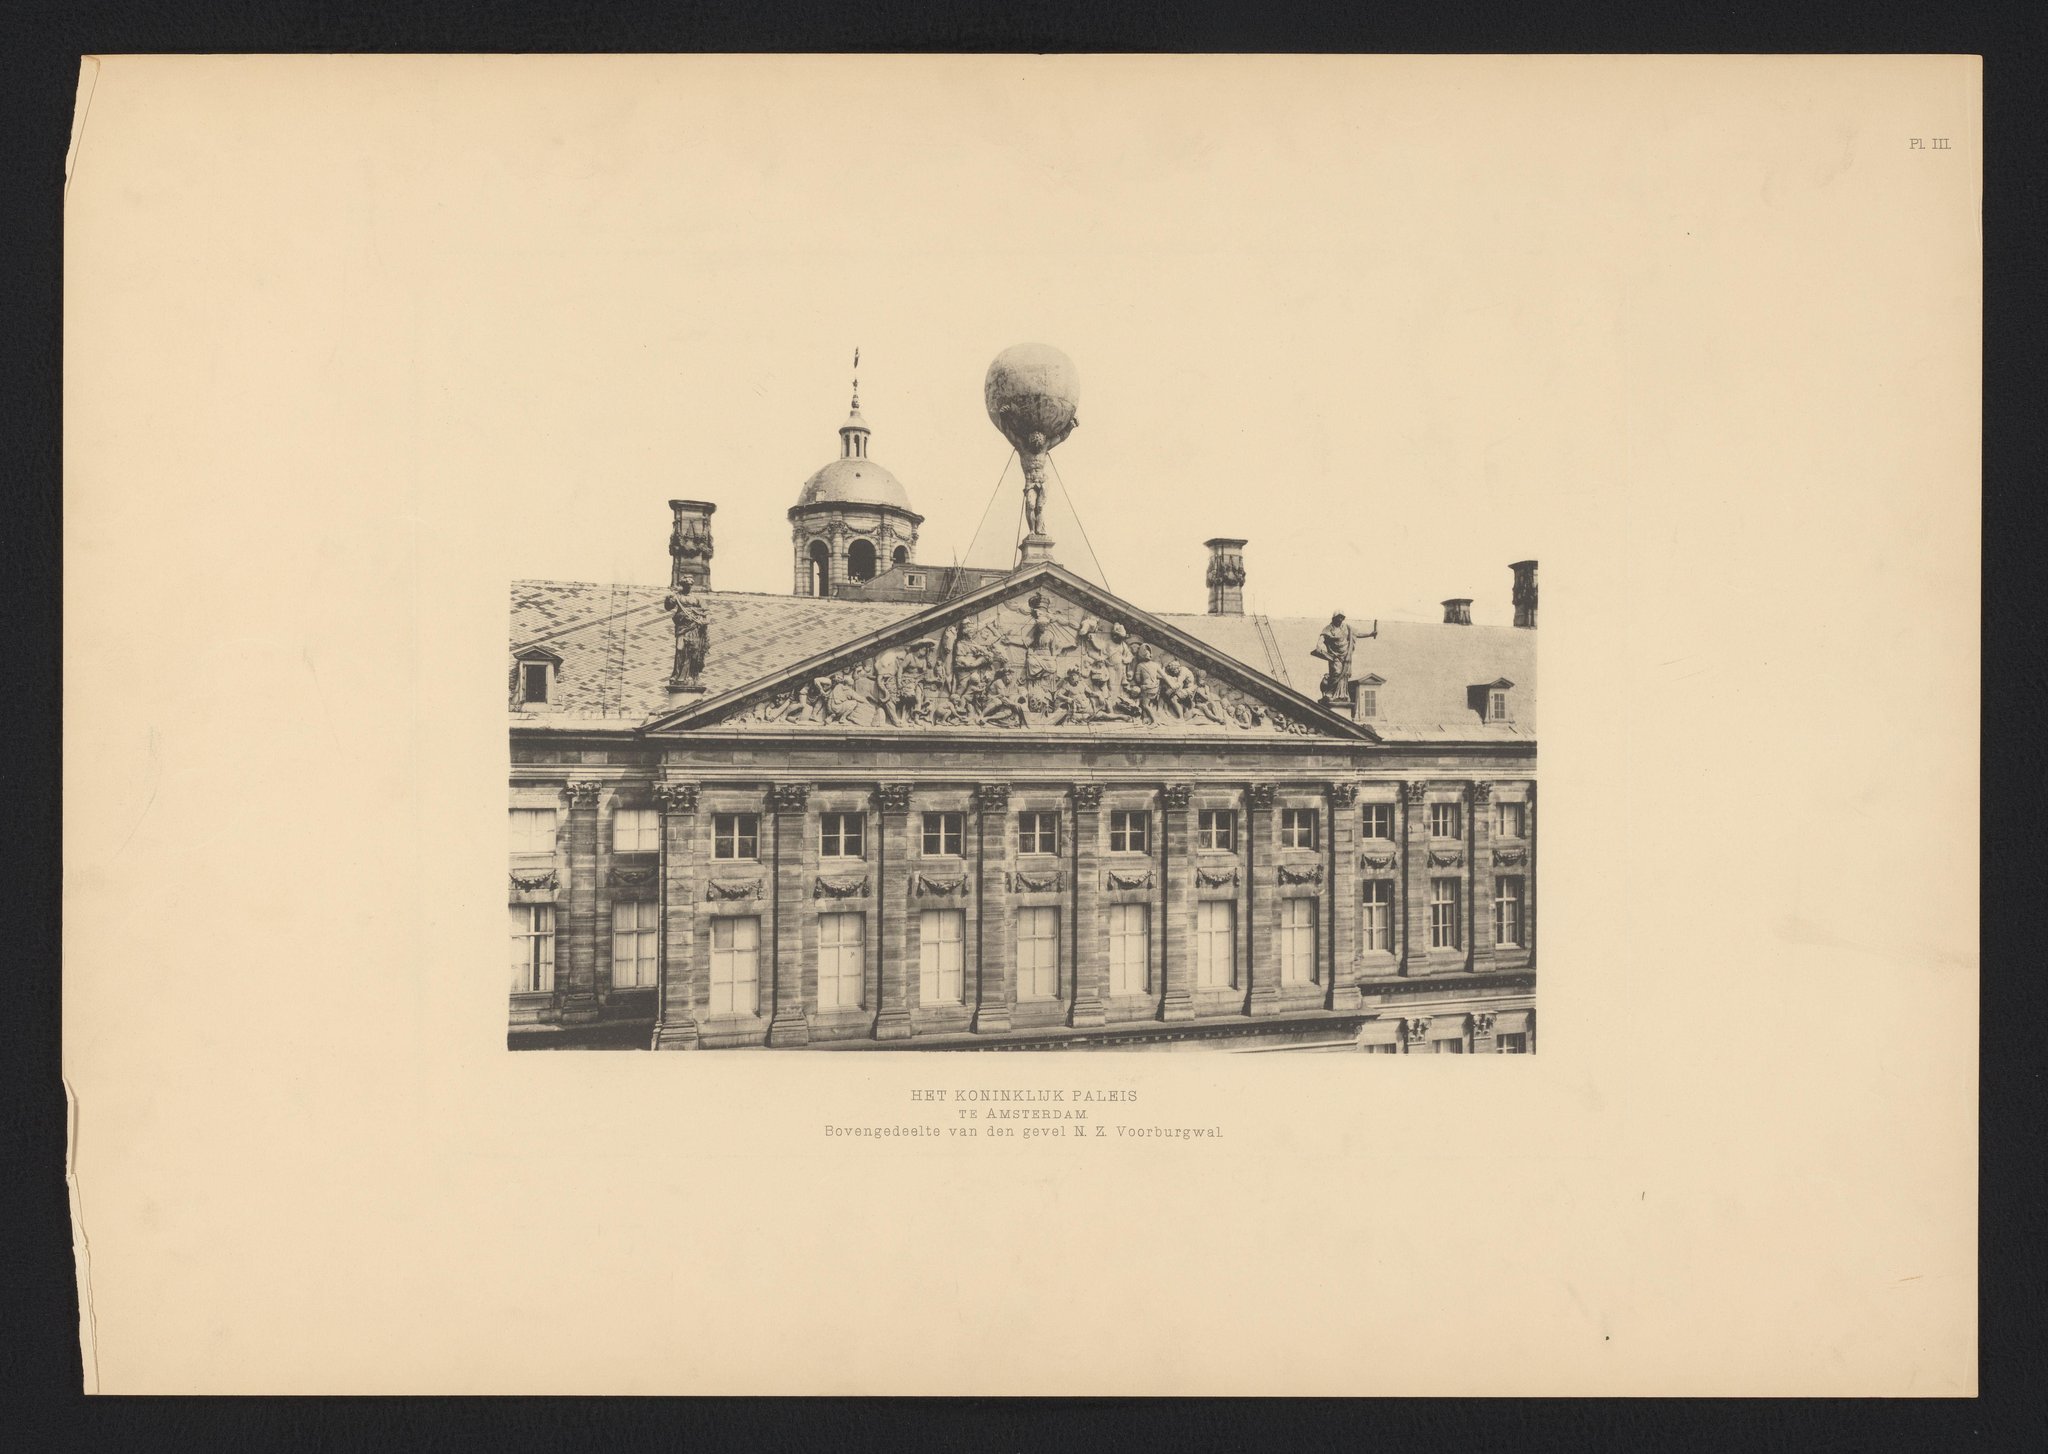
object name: fotomechanisch procedé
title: Het Paleis op de Dam te Amsterdam, bovenzijde van de achtergevel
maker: Anonymous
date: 1899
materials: cardboard, paper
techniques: photograph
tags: palace, royal palace of amsterdam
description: Het Koninklijk Paleis te Amsterdam. Bovengedeelte van den gevel N.Z. Voorburgwal.